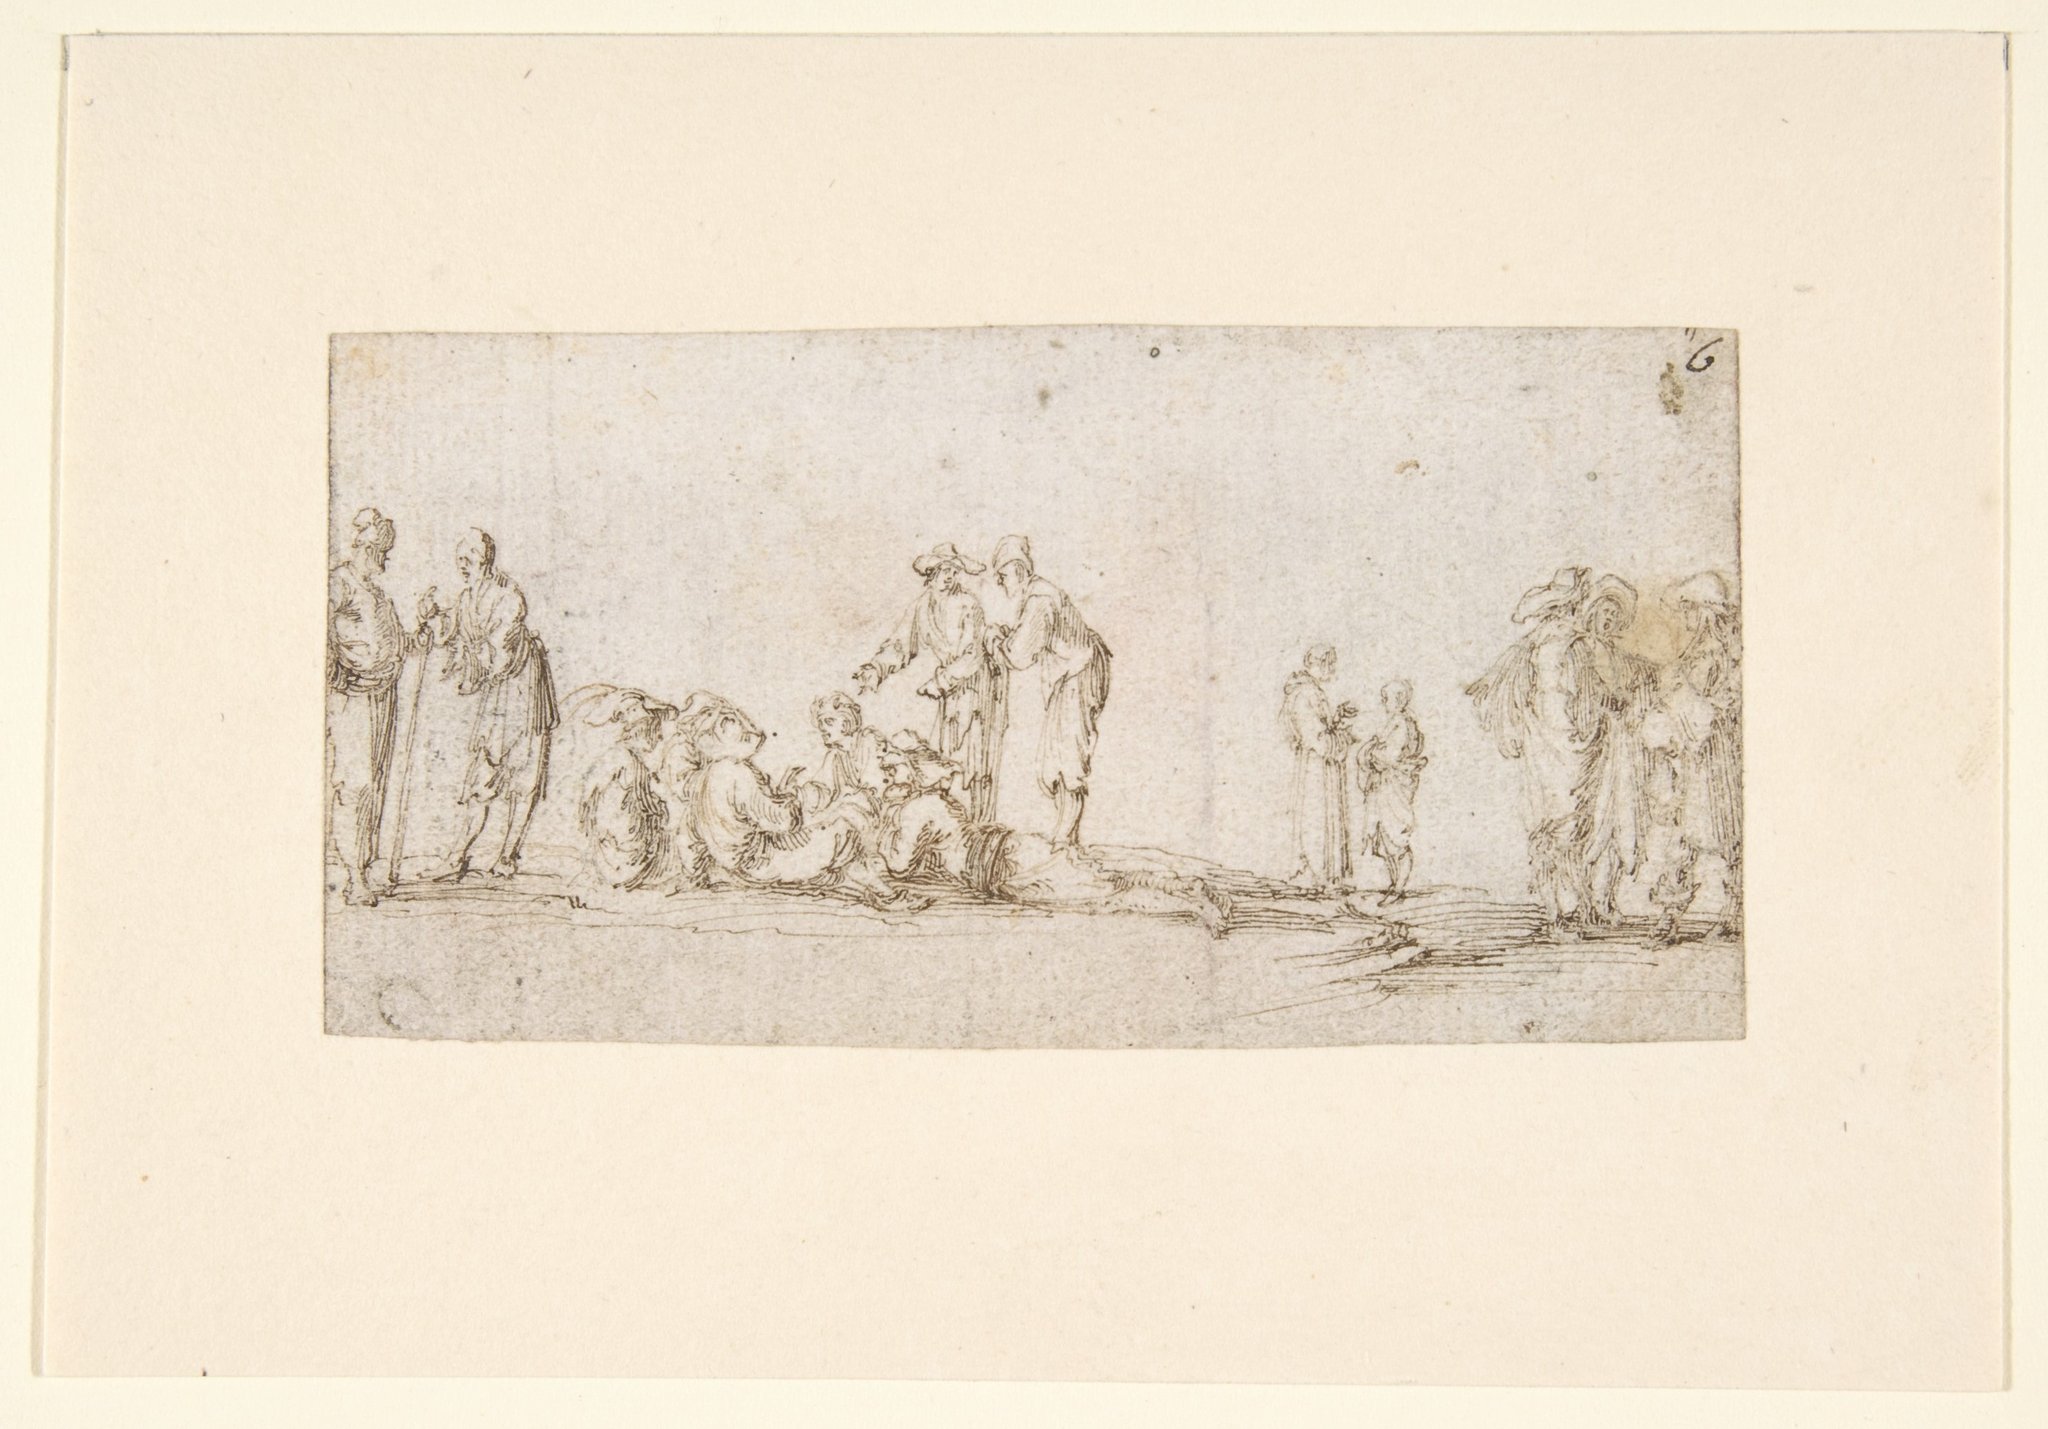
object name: drawing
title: Groups of Men Talking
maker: stefano della bella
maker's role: artist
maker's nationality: italian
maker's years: 1610-1664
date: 1610-1664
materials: ink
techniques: pen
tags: men